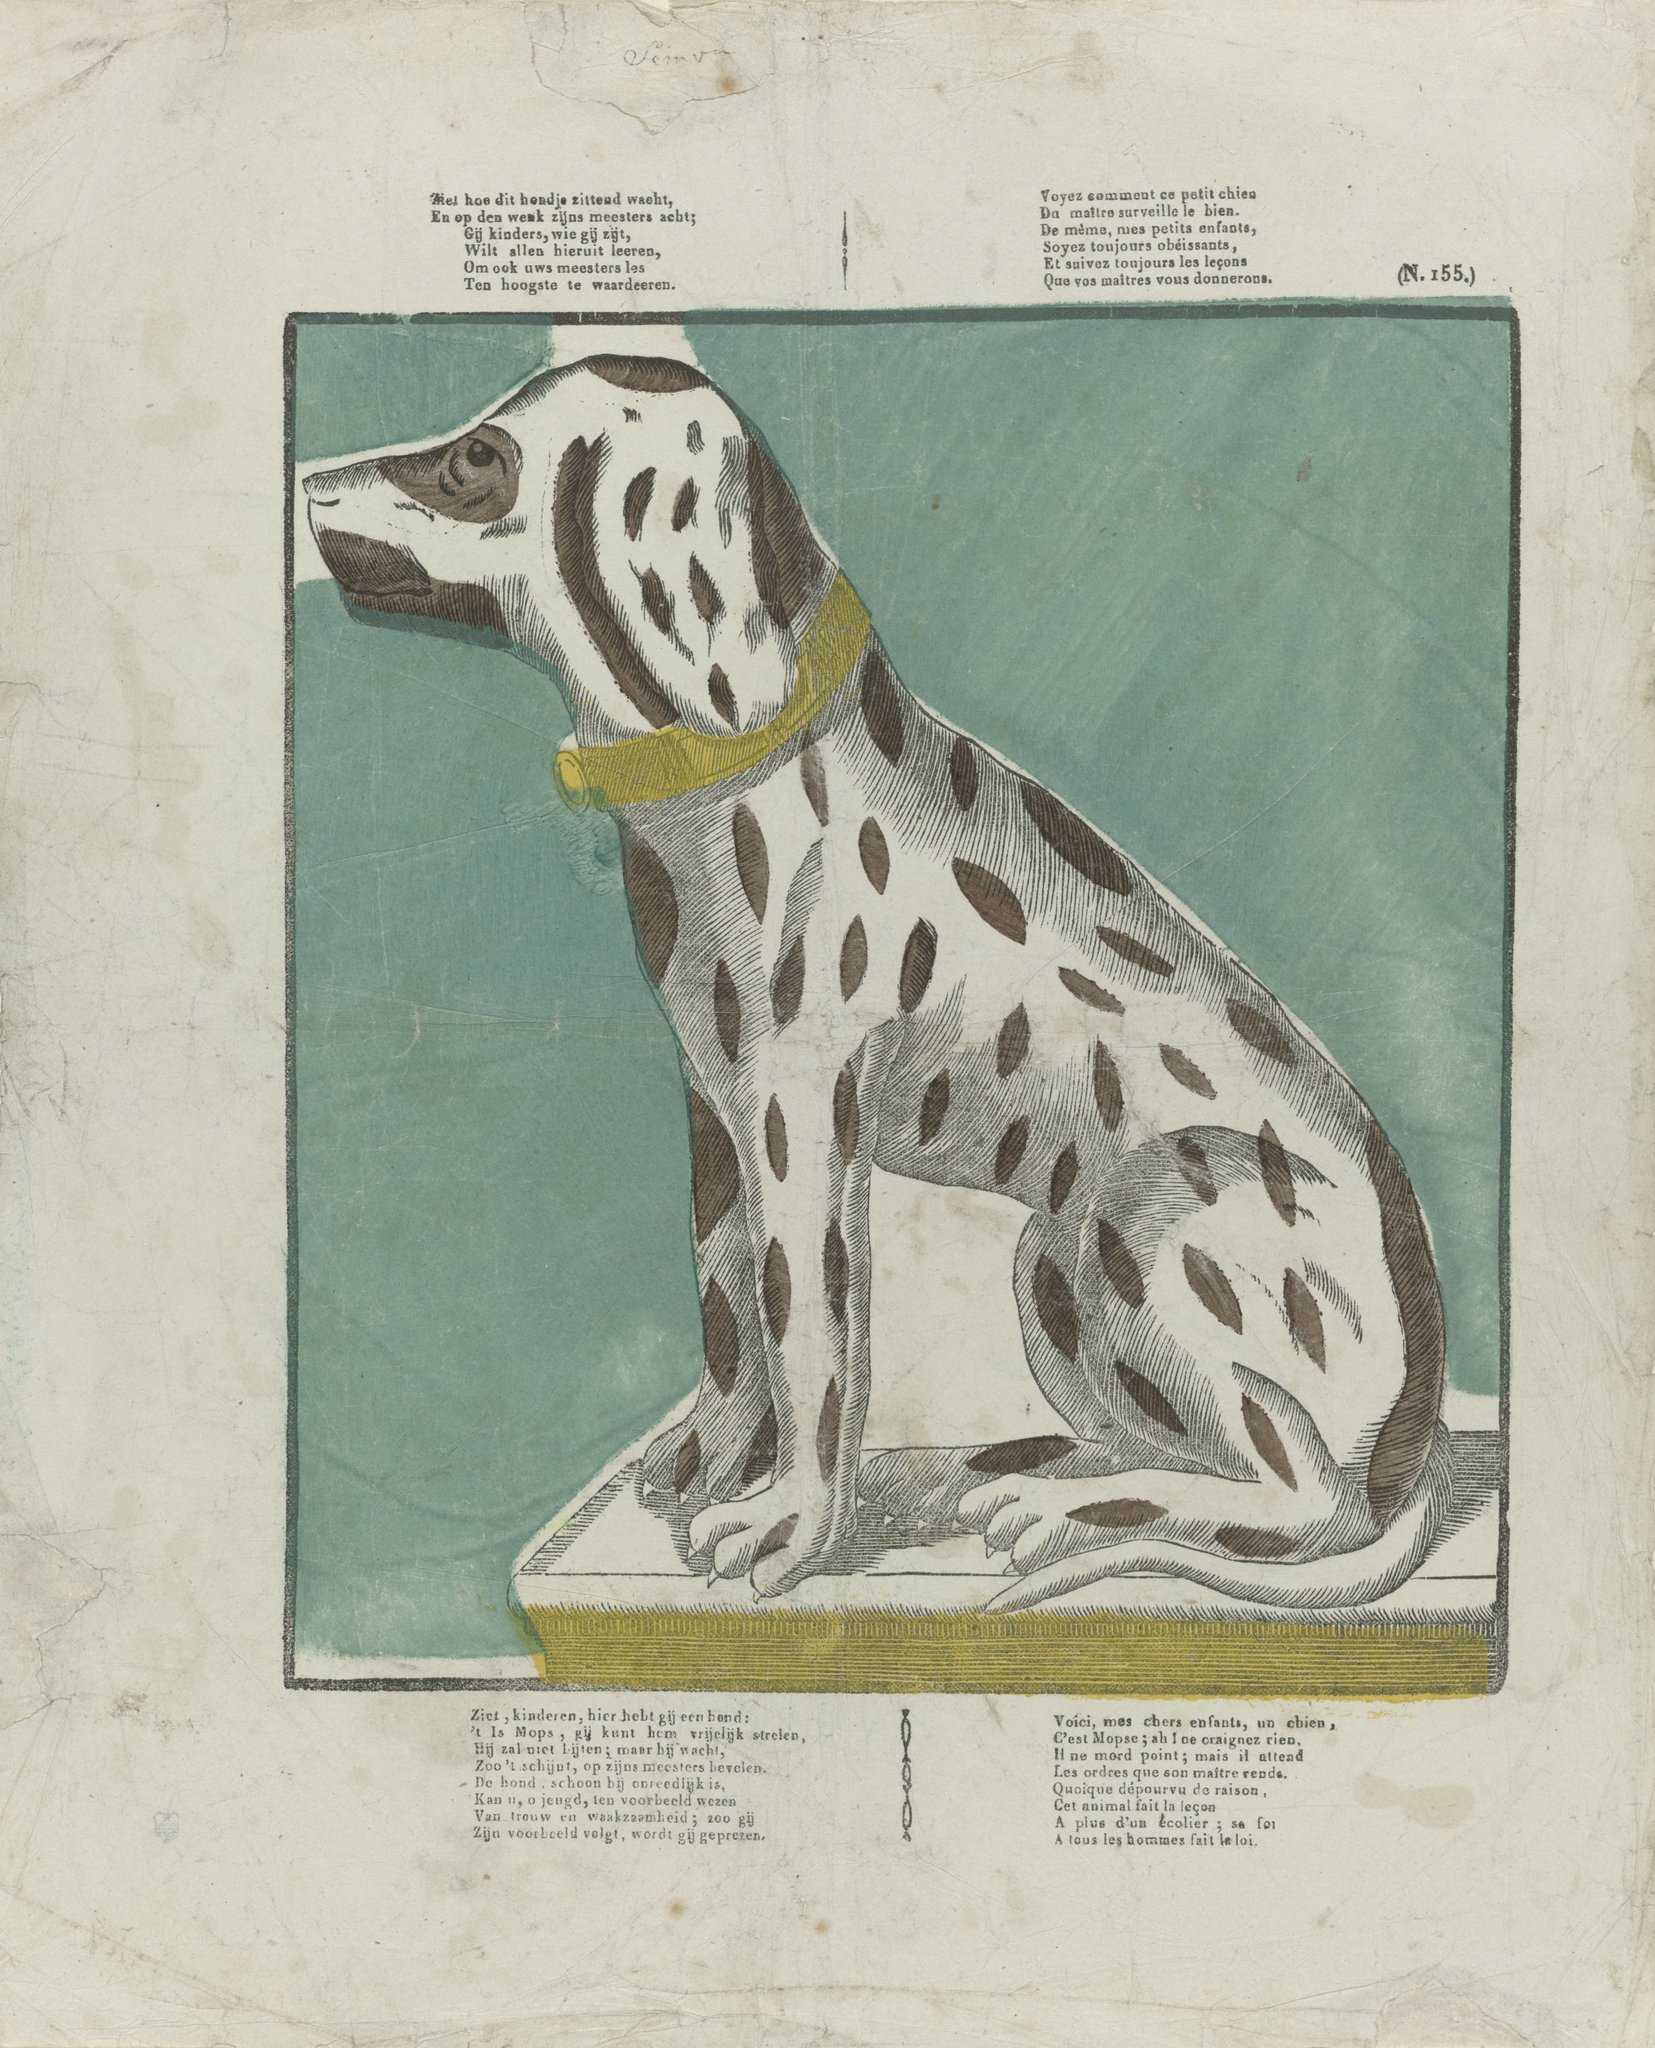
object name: print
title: Ziet hoe dit hondje zittend wacht, / En op den wenk zijns meesters acht [(...)]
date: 1800-1833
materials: paper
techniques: colour, letterpress printing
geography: turnhout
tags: dog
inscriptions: collector's mark: Lugt 2760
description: Zittende hond met vlekken en halsband. Onder de afbeelding een achtregelig vers in het Nederlands en in het Frans. Genummerd rechtsboven: N. 155.